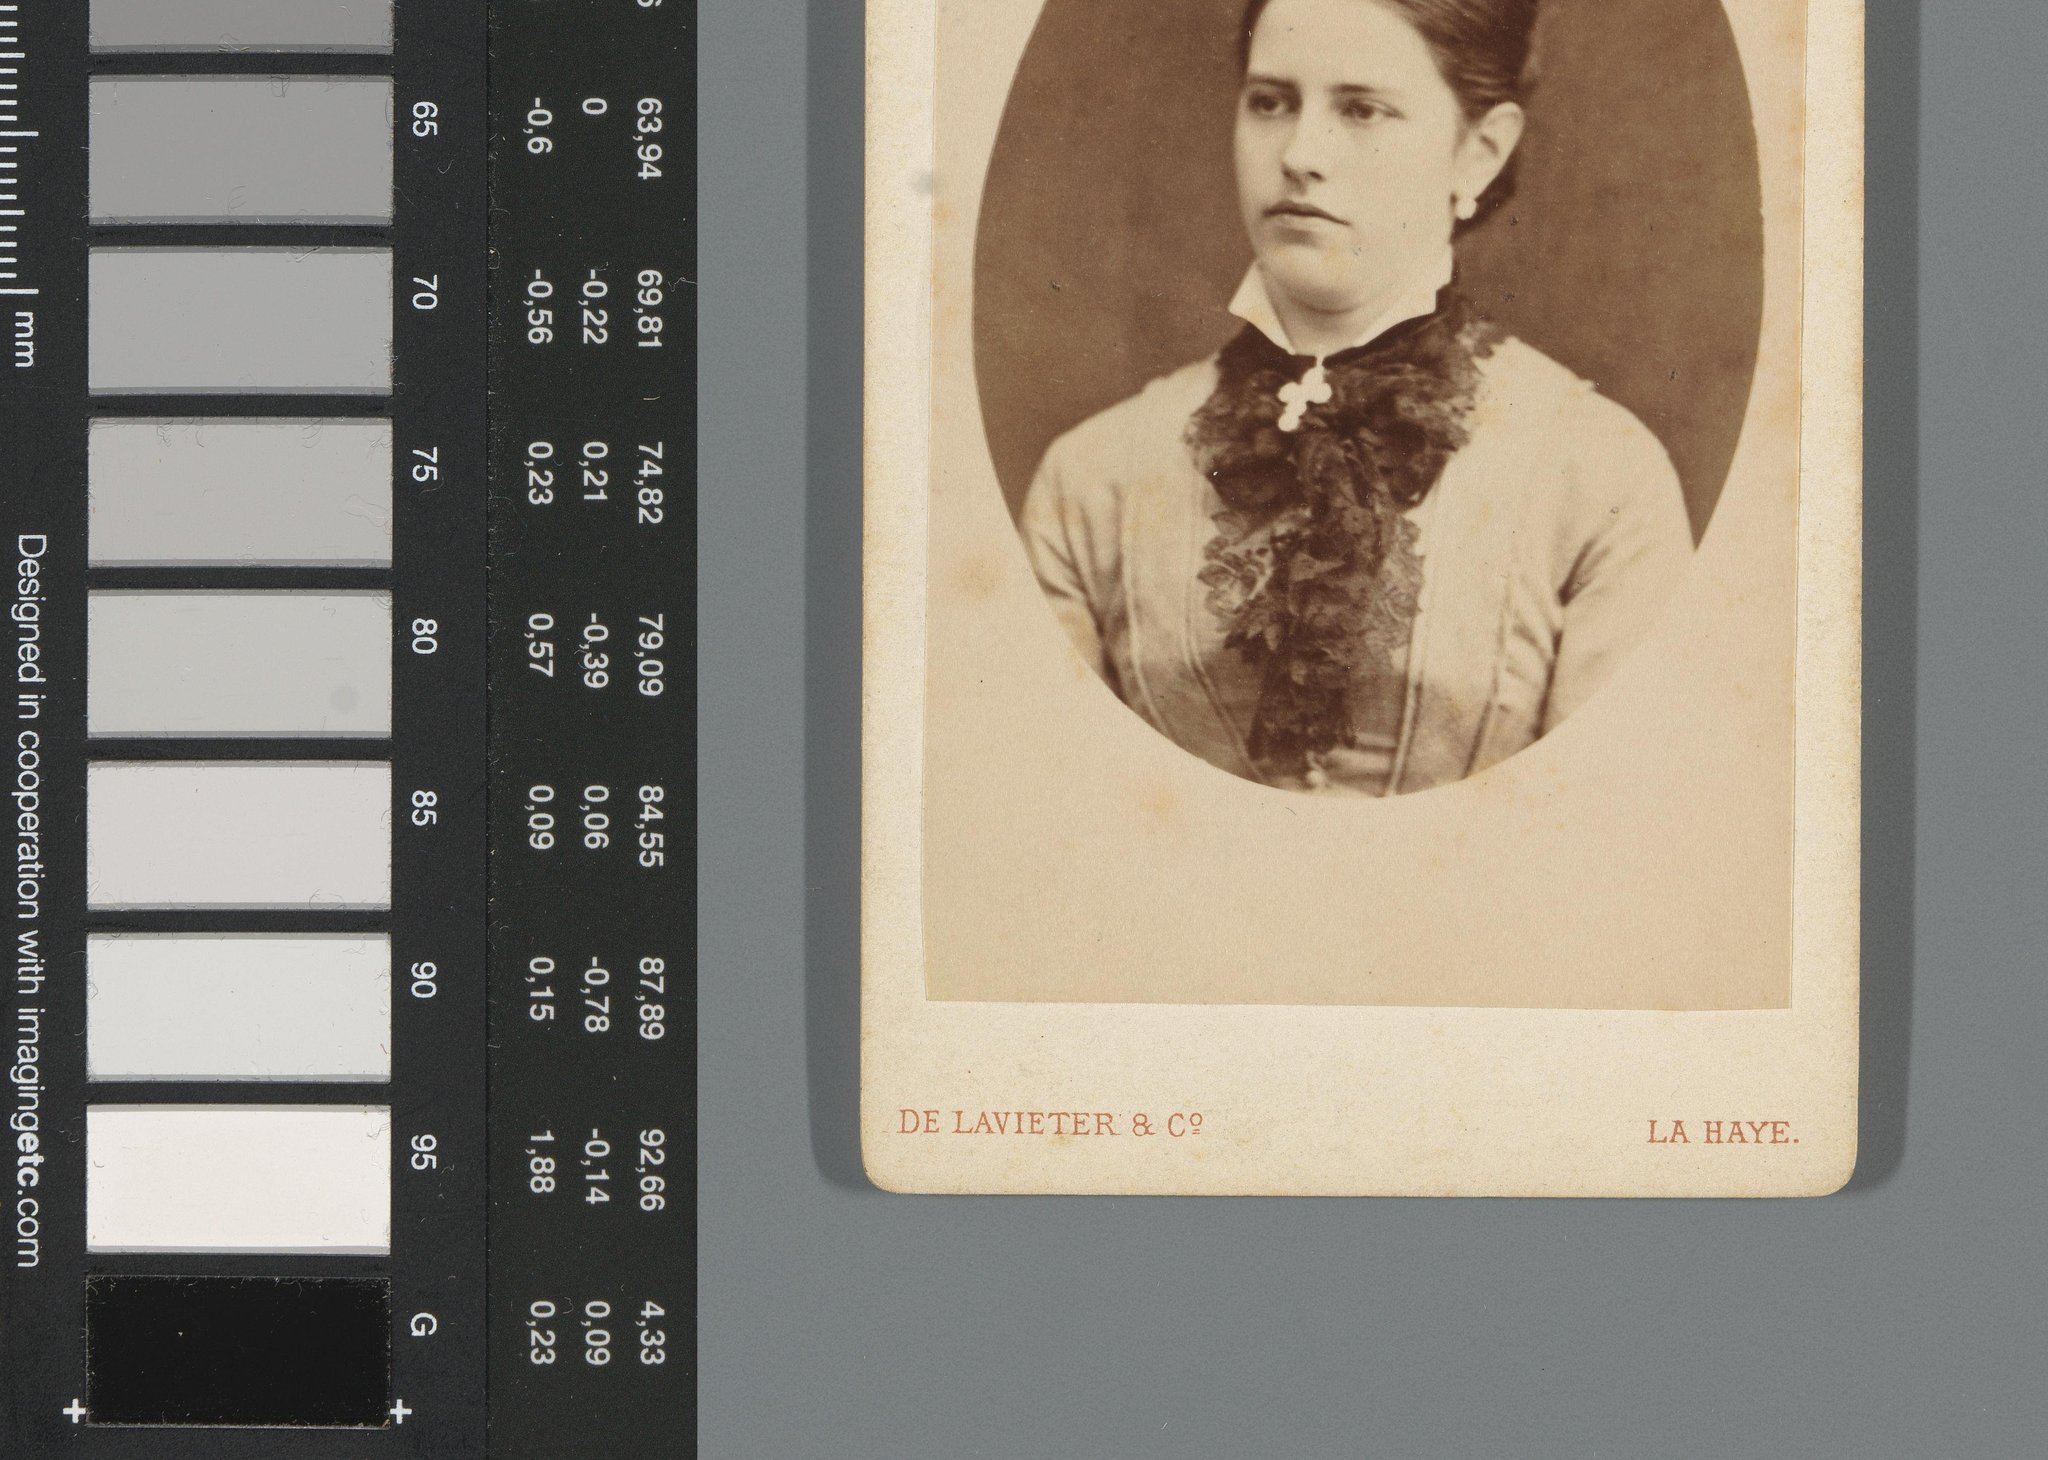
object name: photograph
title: Portret van Susanna Jacoba Hermina des Tombe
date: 1870-1890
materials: cardboard, photographic support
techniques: photography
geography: the hague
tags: haarlem, historical persons - bb - woman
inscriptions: annotation: ‘Suz. J. Herm. TvB-des Tombe’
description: Portret van Susanna Jacoba Hermina des Tombe, ovaal.